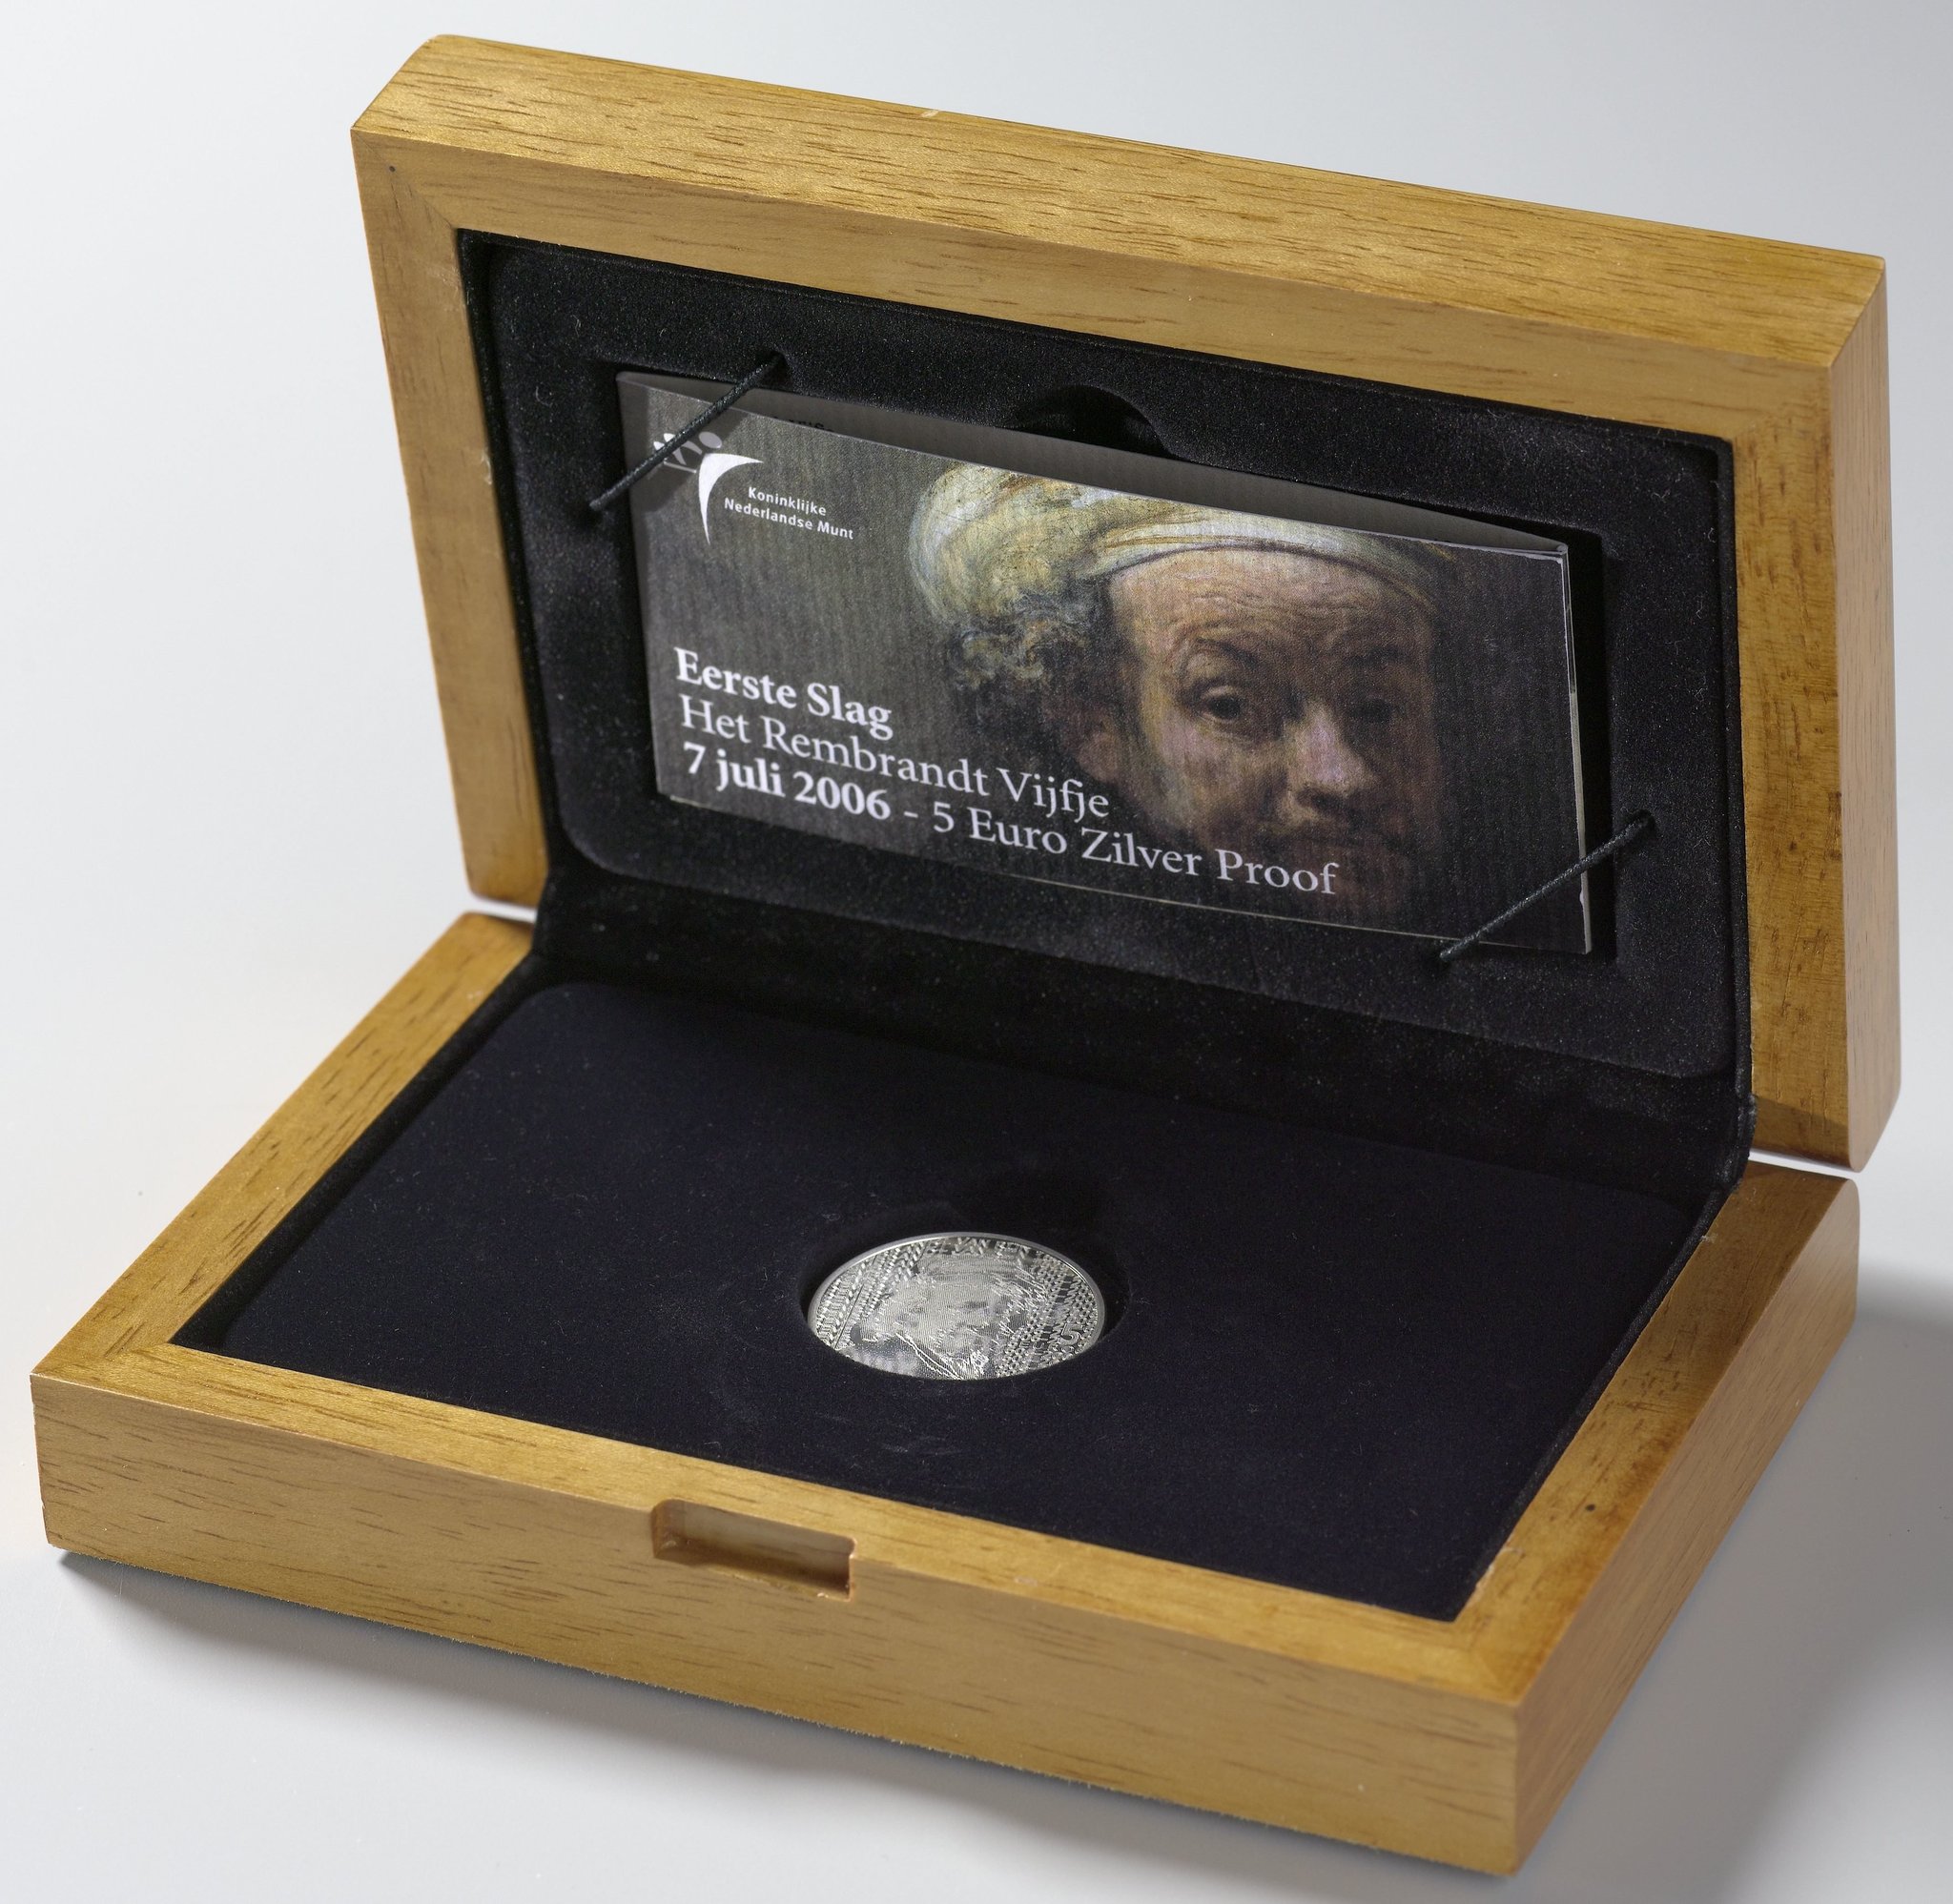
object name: box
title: Houten doosje bij munt Het Rembrandt Vijfje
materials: metal, paper, velvet, wood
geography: utrecht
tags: leiden, amsterdam, painter, print maker, draughtsman, rembrandt van rijn, netherlands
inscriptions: inscription: ‘Eerste slag Rembrandt Vijfje Juli 2006 te Leiden’, inscription: ‘Koninklijke Nederlandse Munt’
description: Houten doosje met scharnierend deksel met opschrift. Onderzijde mosgroen fluweel. Binnenzijde blauw fluweel met uitsparing voor munt en in de deksel een uitsparing met elastiek voor inlegvelletje waarop informatie over de munt.